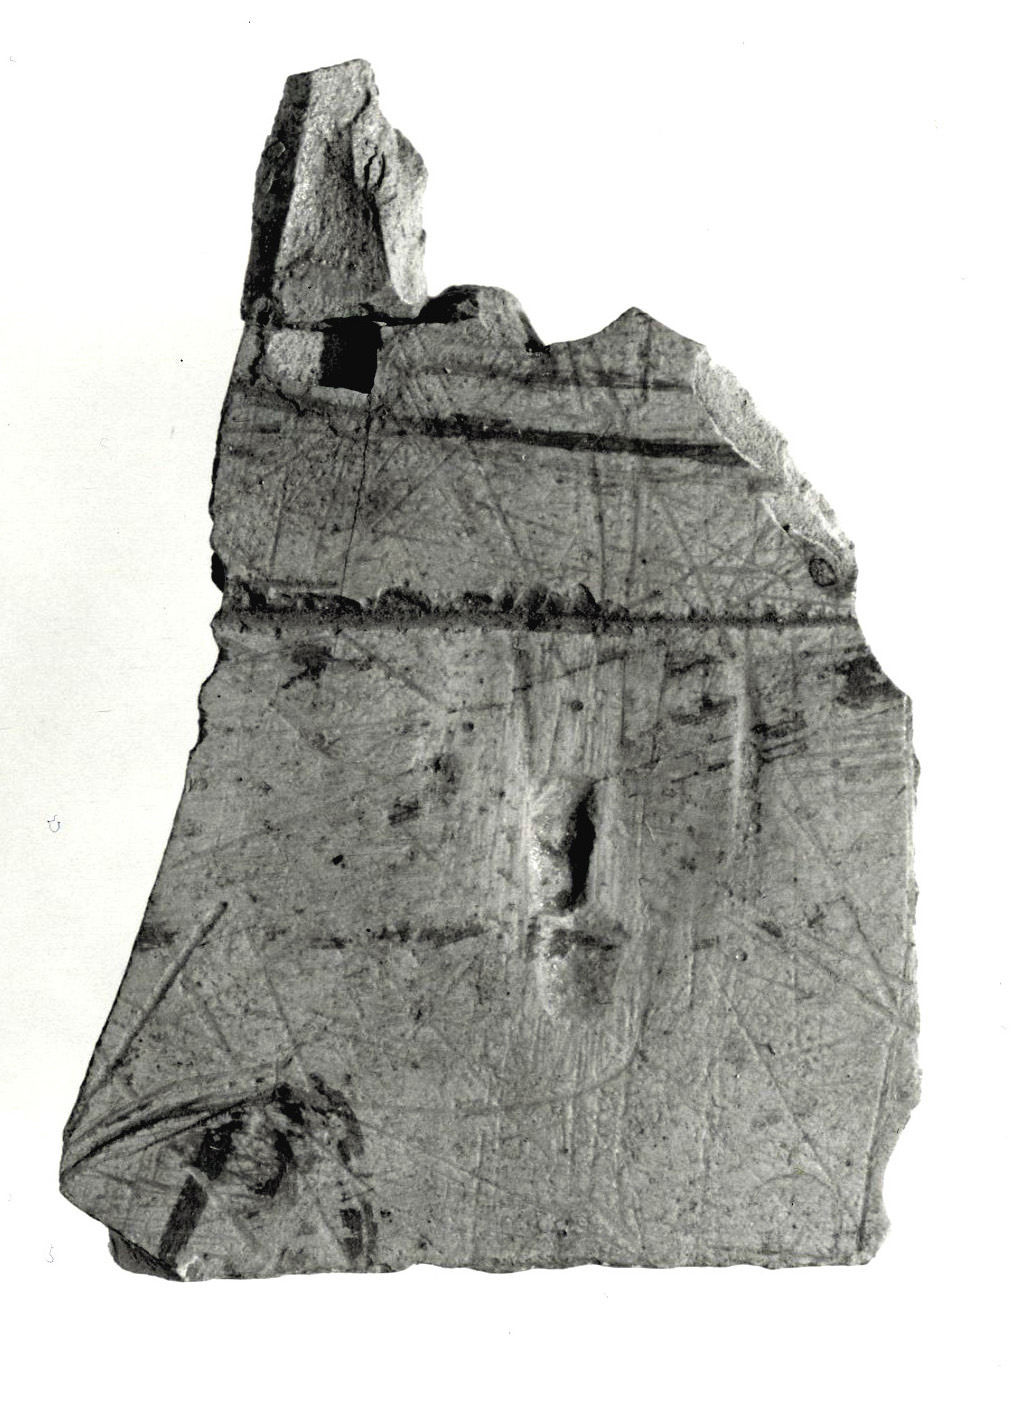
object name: relief, tomb of nespekashuty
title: Drawing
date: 664-610 BCE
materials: limestone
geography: egypt